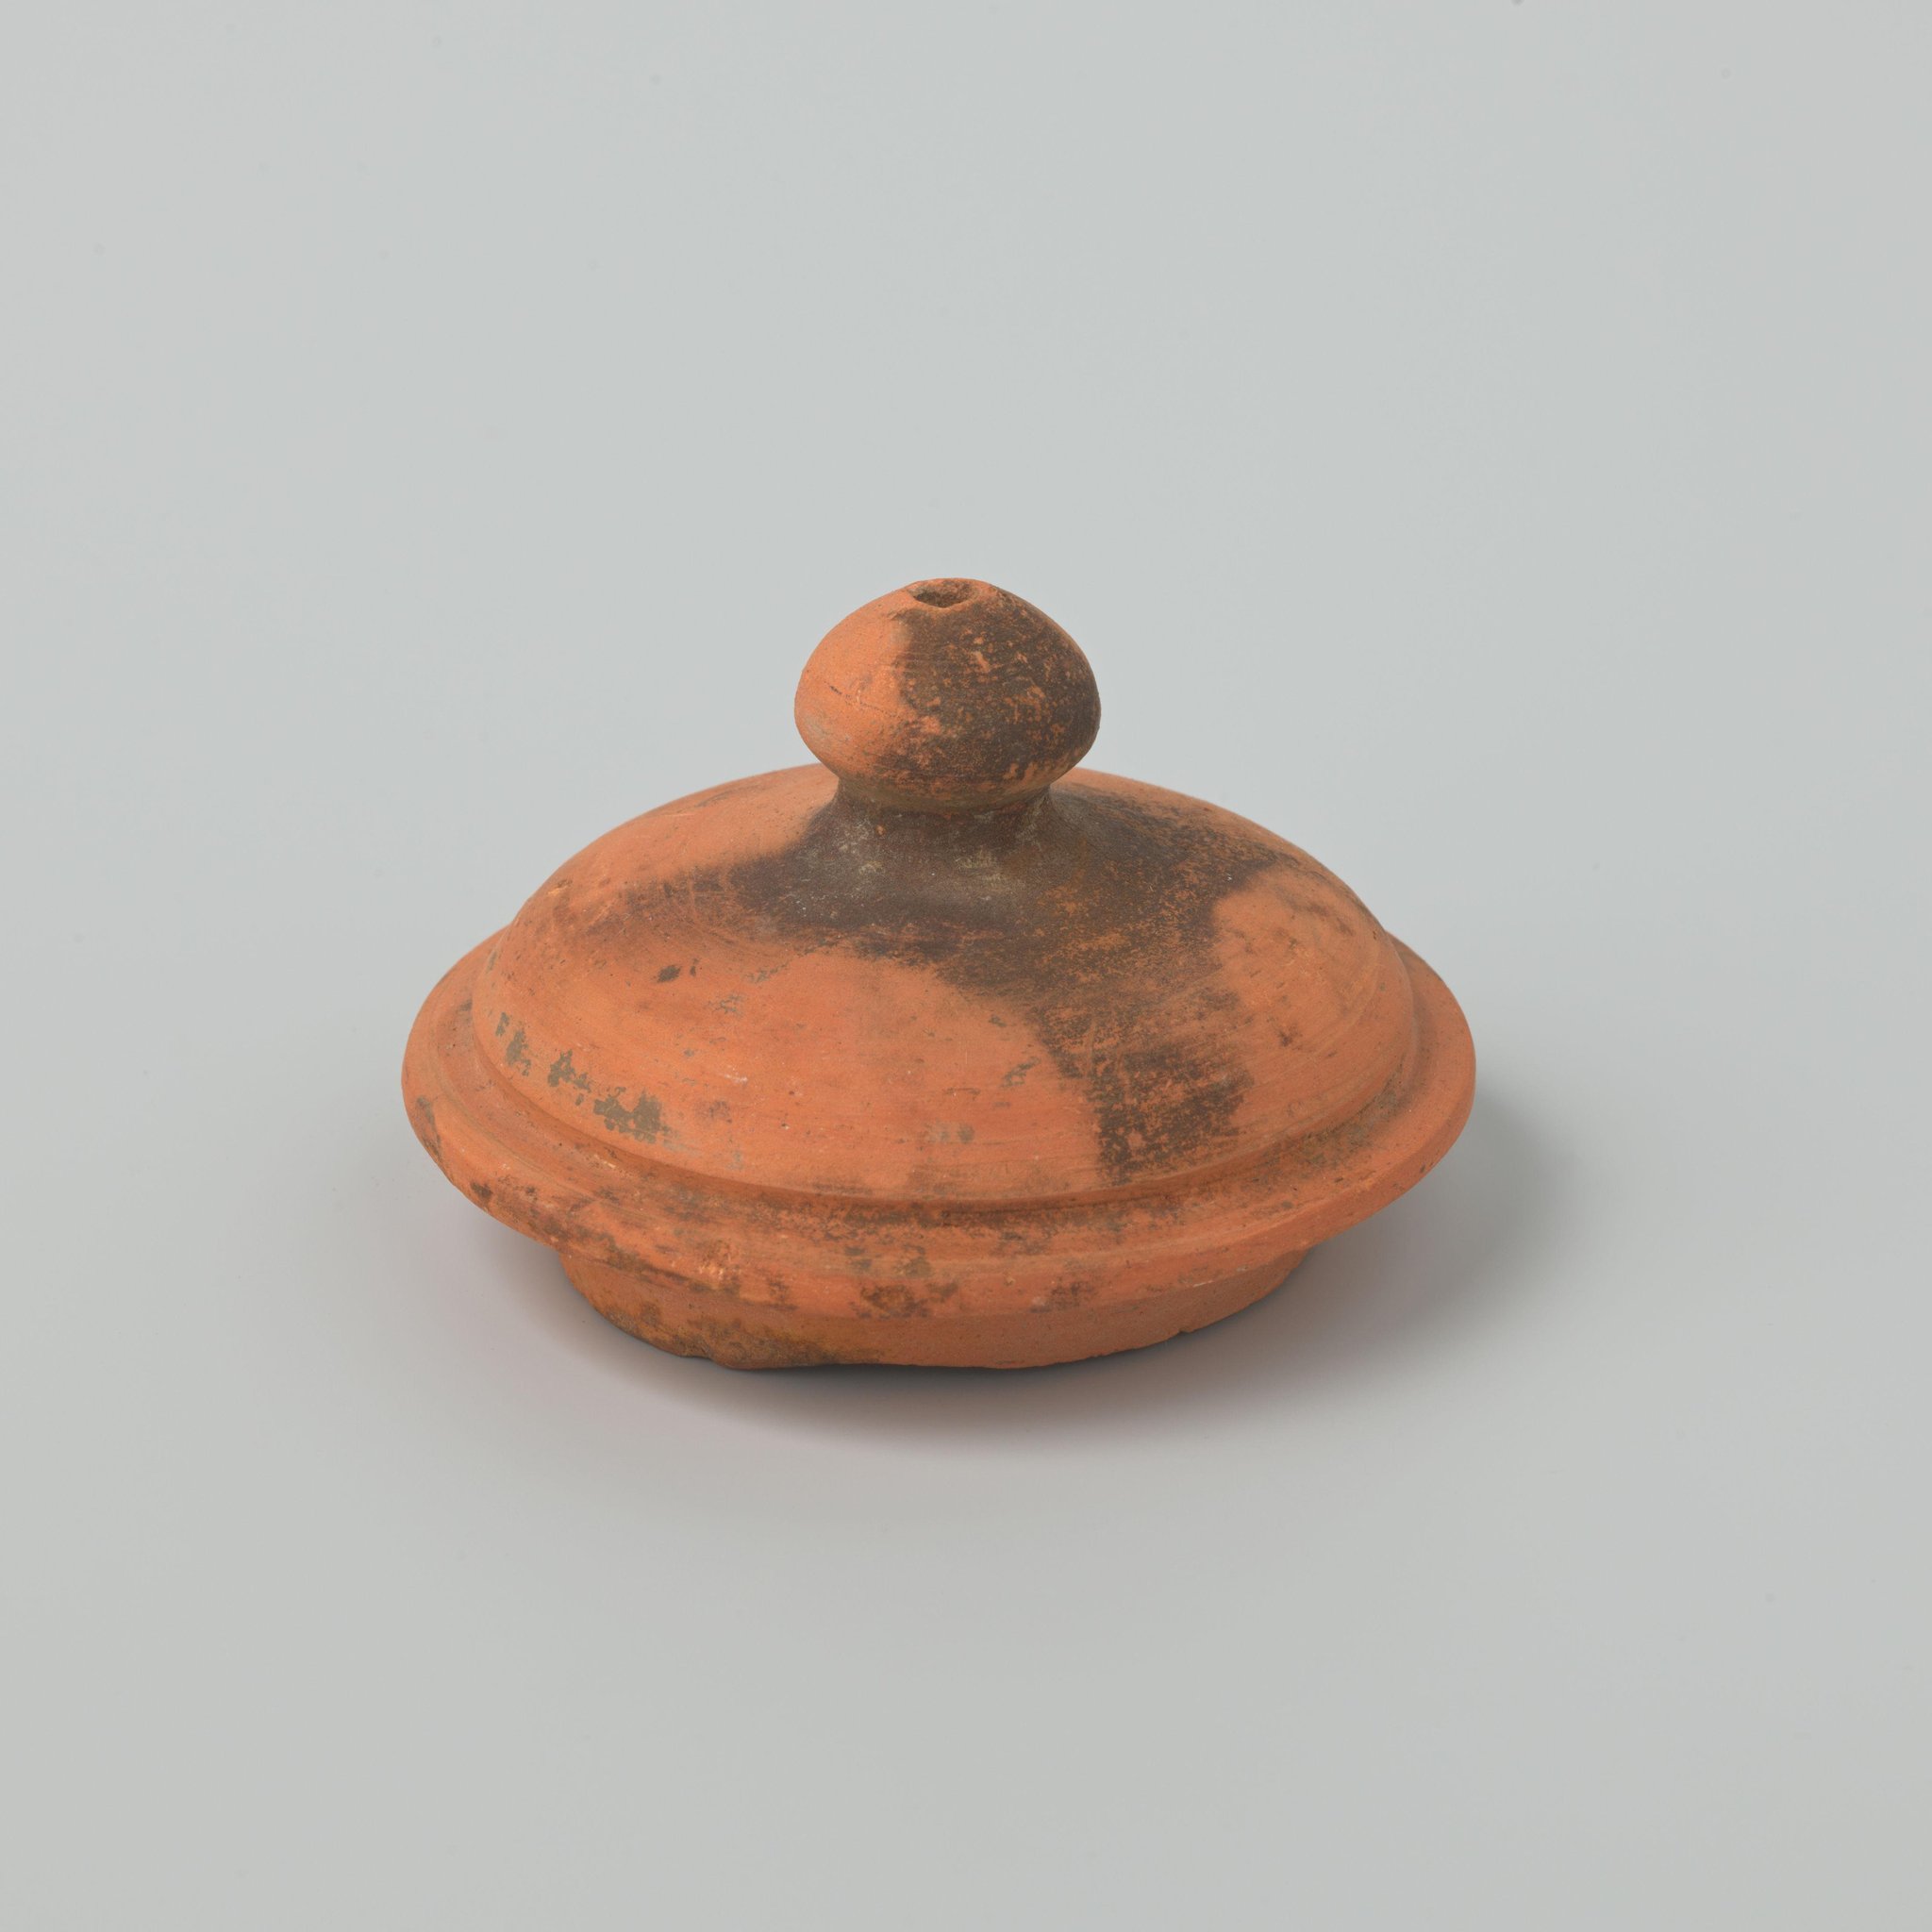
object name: lid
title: Deksel van een theepot (De Caluwe bakafval)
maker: jacobus de caluwe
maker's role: plateelbakkerij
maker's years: -1730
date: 1700-1725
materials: earthenware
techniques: firing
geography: delft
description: Toegeschreven aan Jacobus de Caluwe, omdat dit voorwerp samen met gemerkte stukken (‘Jacobus De Caluwe’ en rennend hert) gevonden is op de plaats waar zich De Caluwes tweede werkplaats bevond. Er is een duidelijke stilistische overeenkomst tussen de gemerkte en niet gemerkte voorwerpen uit deze archeologische vondst.